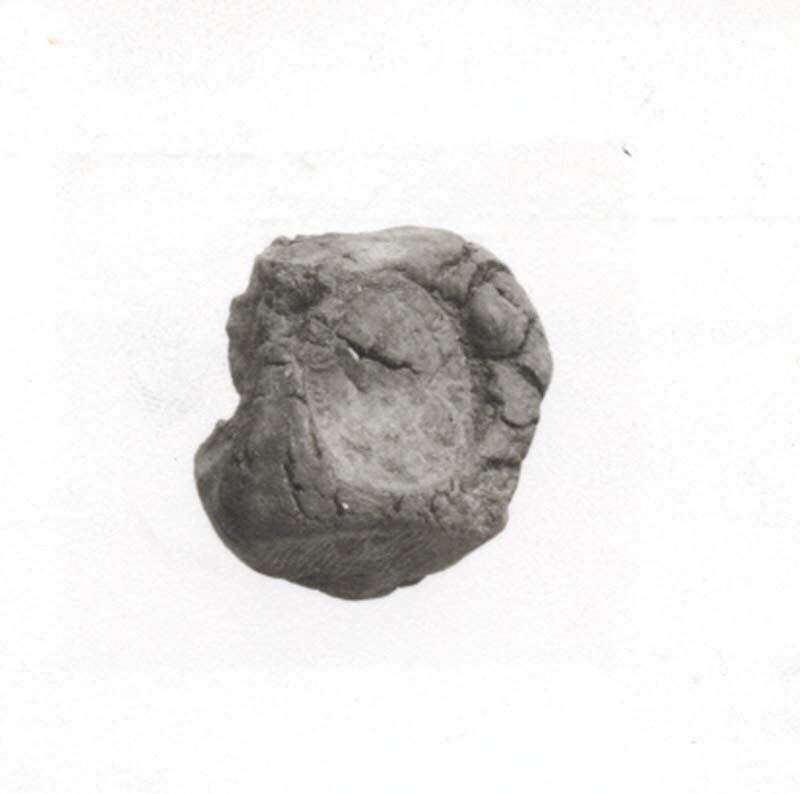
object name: sealing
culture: sasanian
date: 601-700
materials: clay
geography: iran